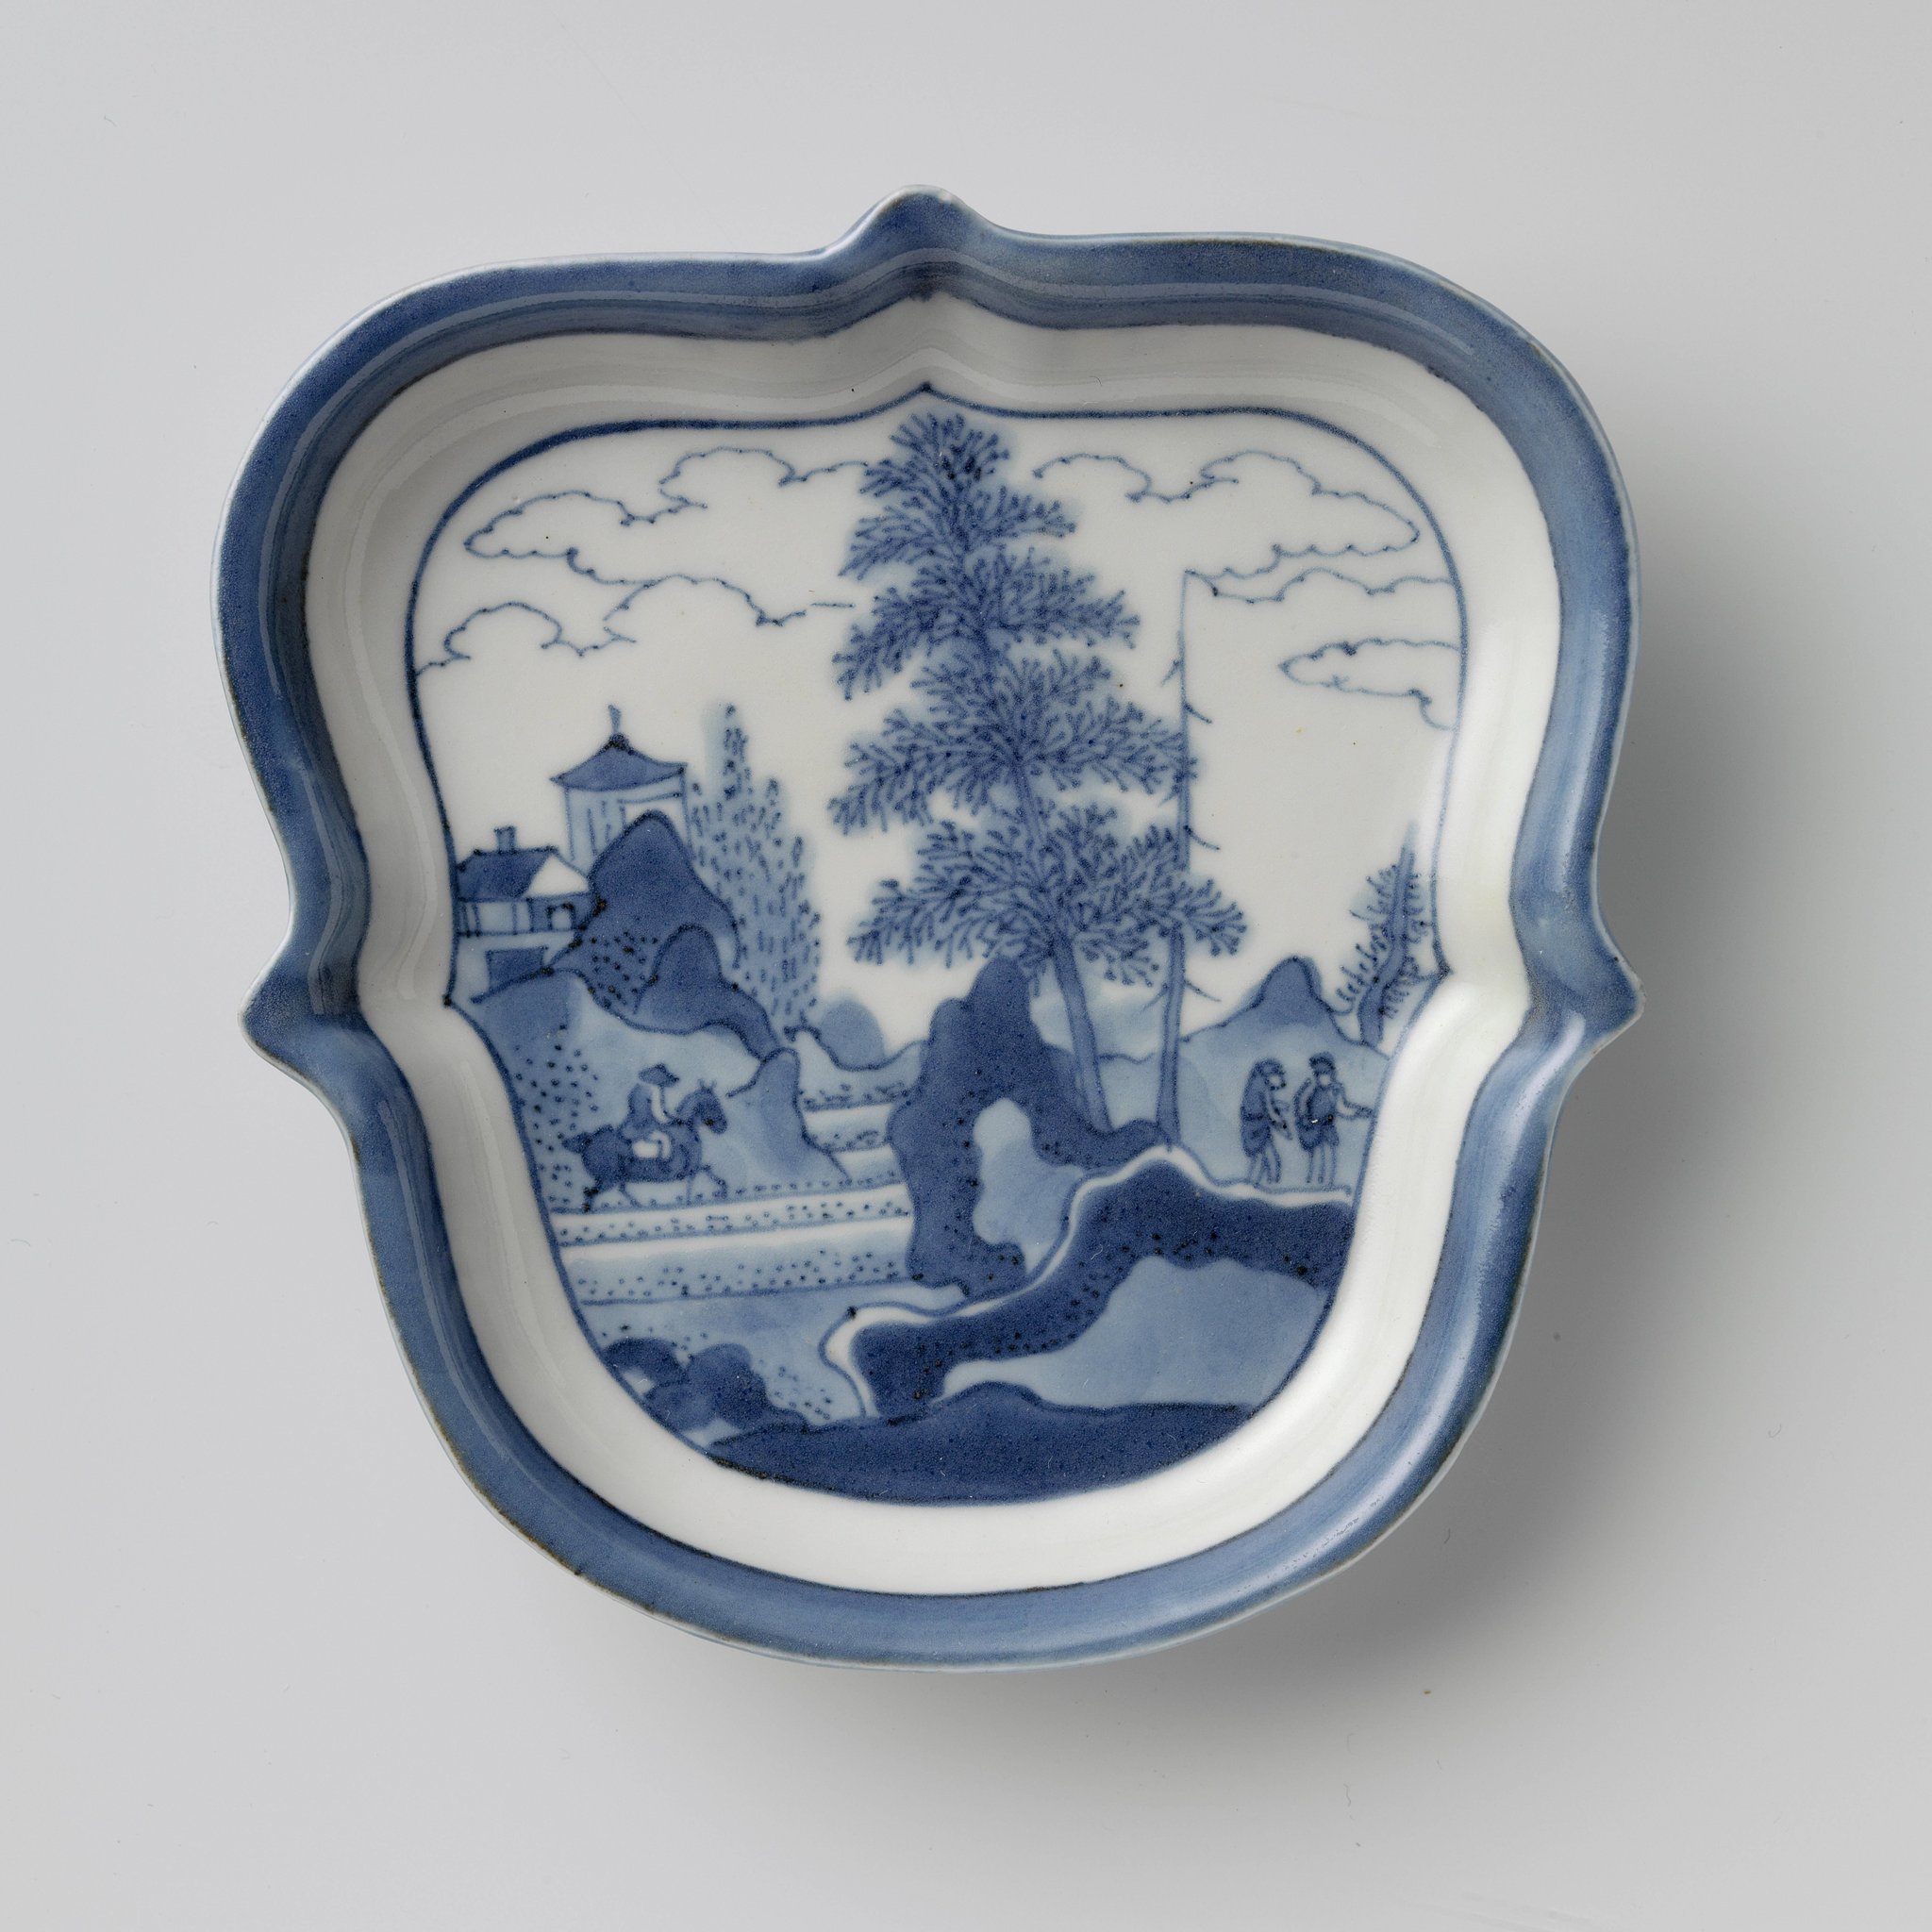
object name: dish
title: Two Dishes and a Plate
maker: Anonymous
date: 1700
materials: cobalt, glaze, paint, porcelain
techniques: firing, forming, vitrification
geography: japan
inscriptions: mark: ‘大 明 成 化 年 製 dà míng Chénghuà nián zhì’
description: Landscapes with European-looking figures and buildings appear in many variations on Japanese export porcelain meant for the European market. They were probably based on Dutch prints, or Delftware, which may explain why the clouds are depicted in a European manner.